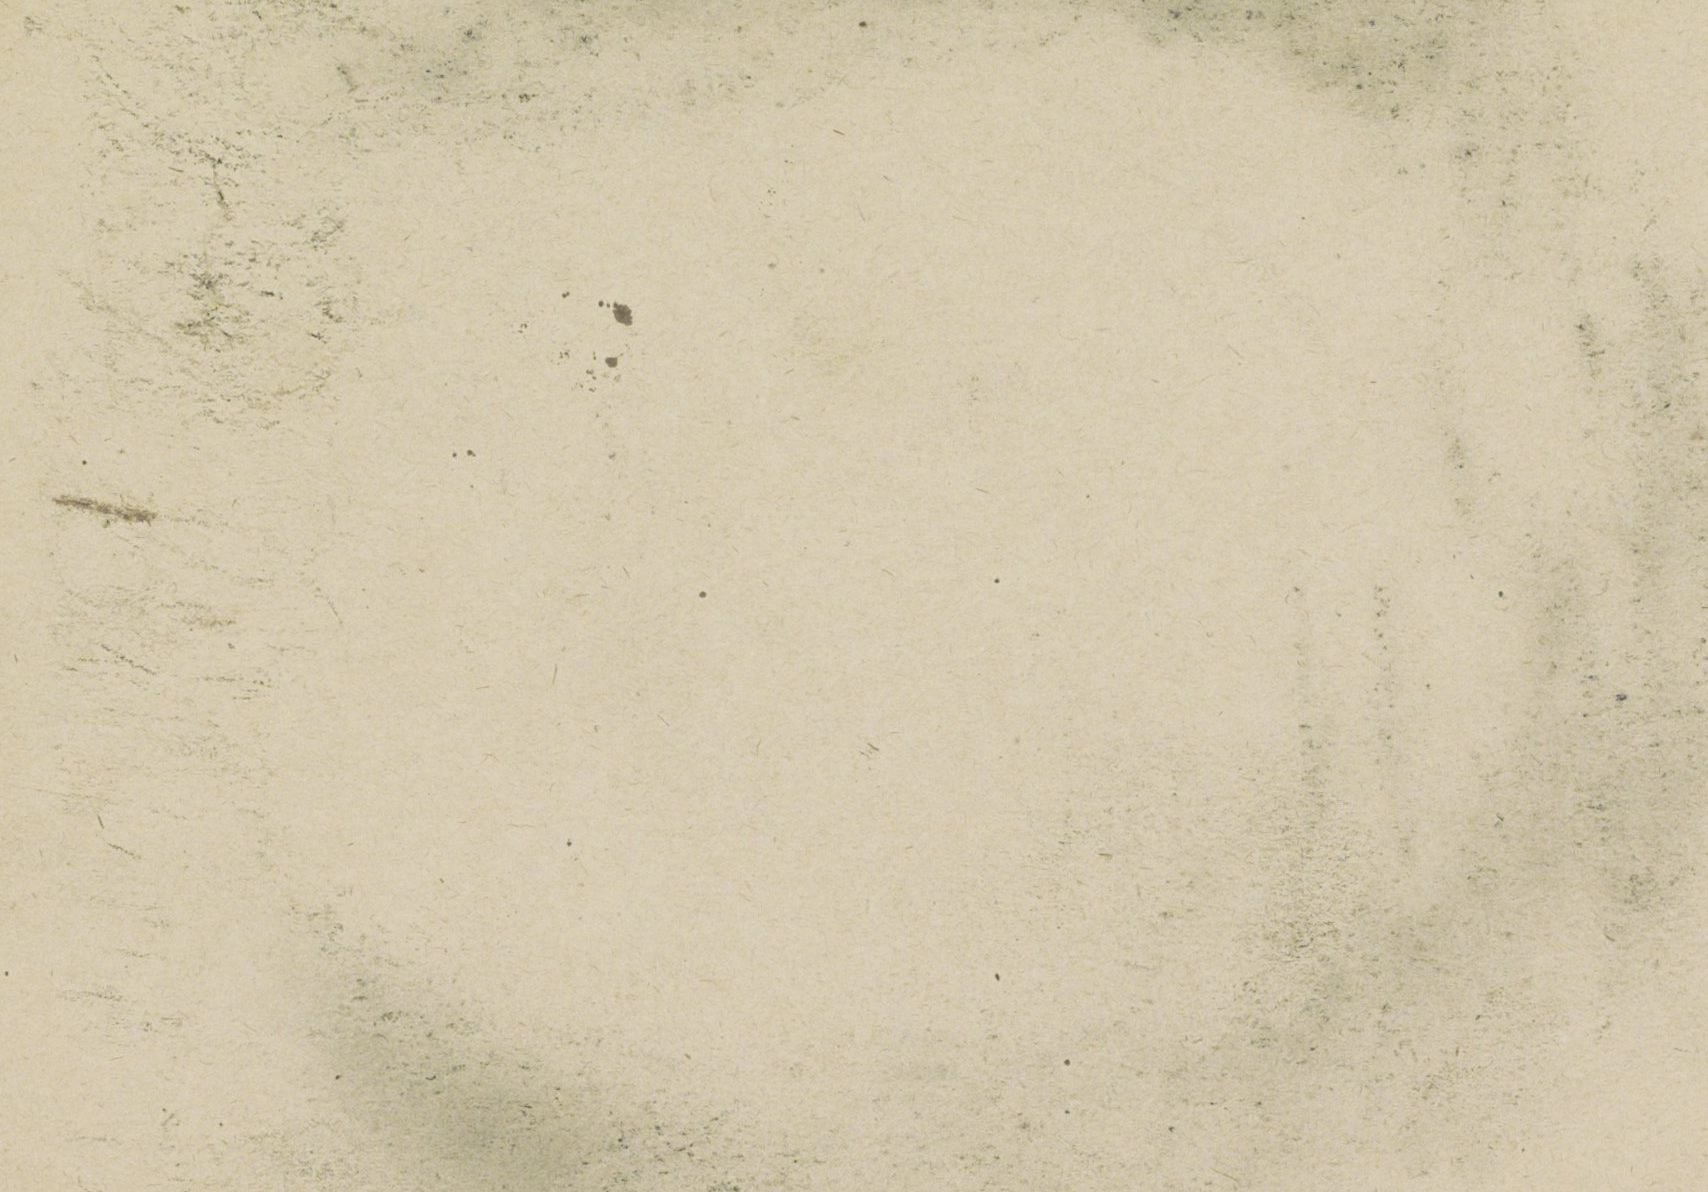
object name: sketchbook leaf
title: Abklatsch van de krijttekening op pagina 26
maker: willem witsen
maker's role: draughtsman, painter, print maker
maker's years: 1860-1923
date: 1887-1920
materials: paper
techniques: printmaking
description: Pagina 27 uit een schetsboek met 12 bladen.